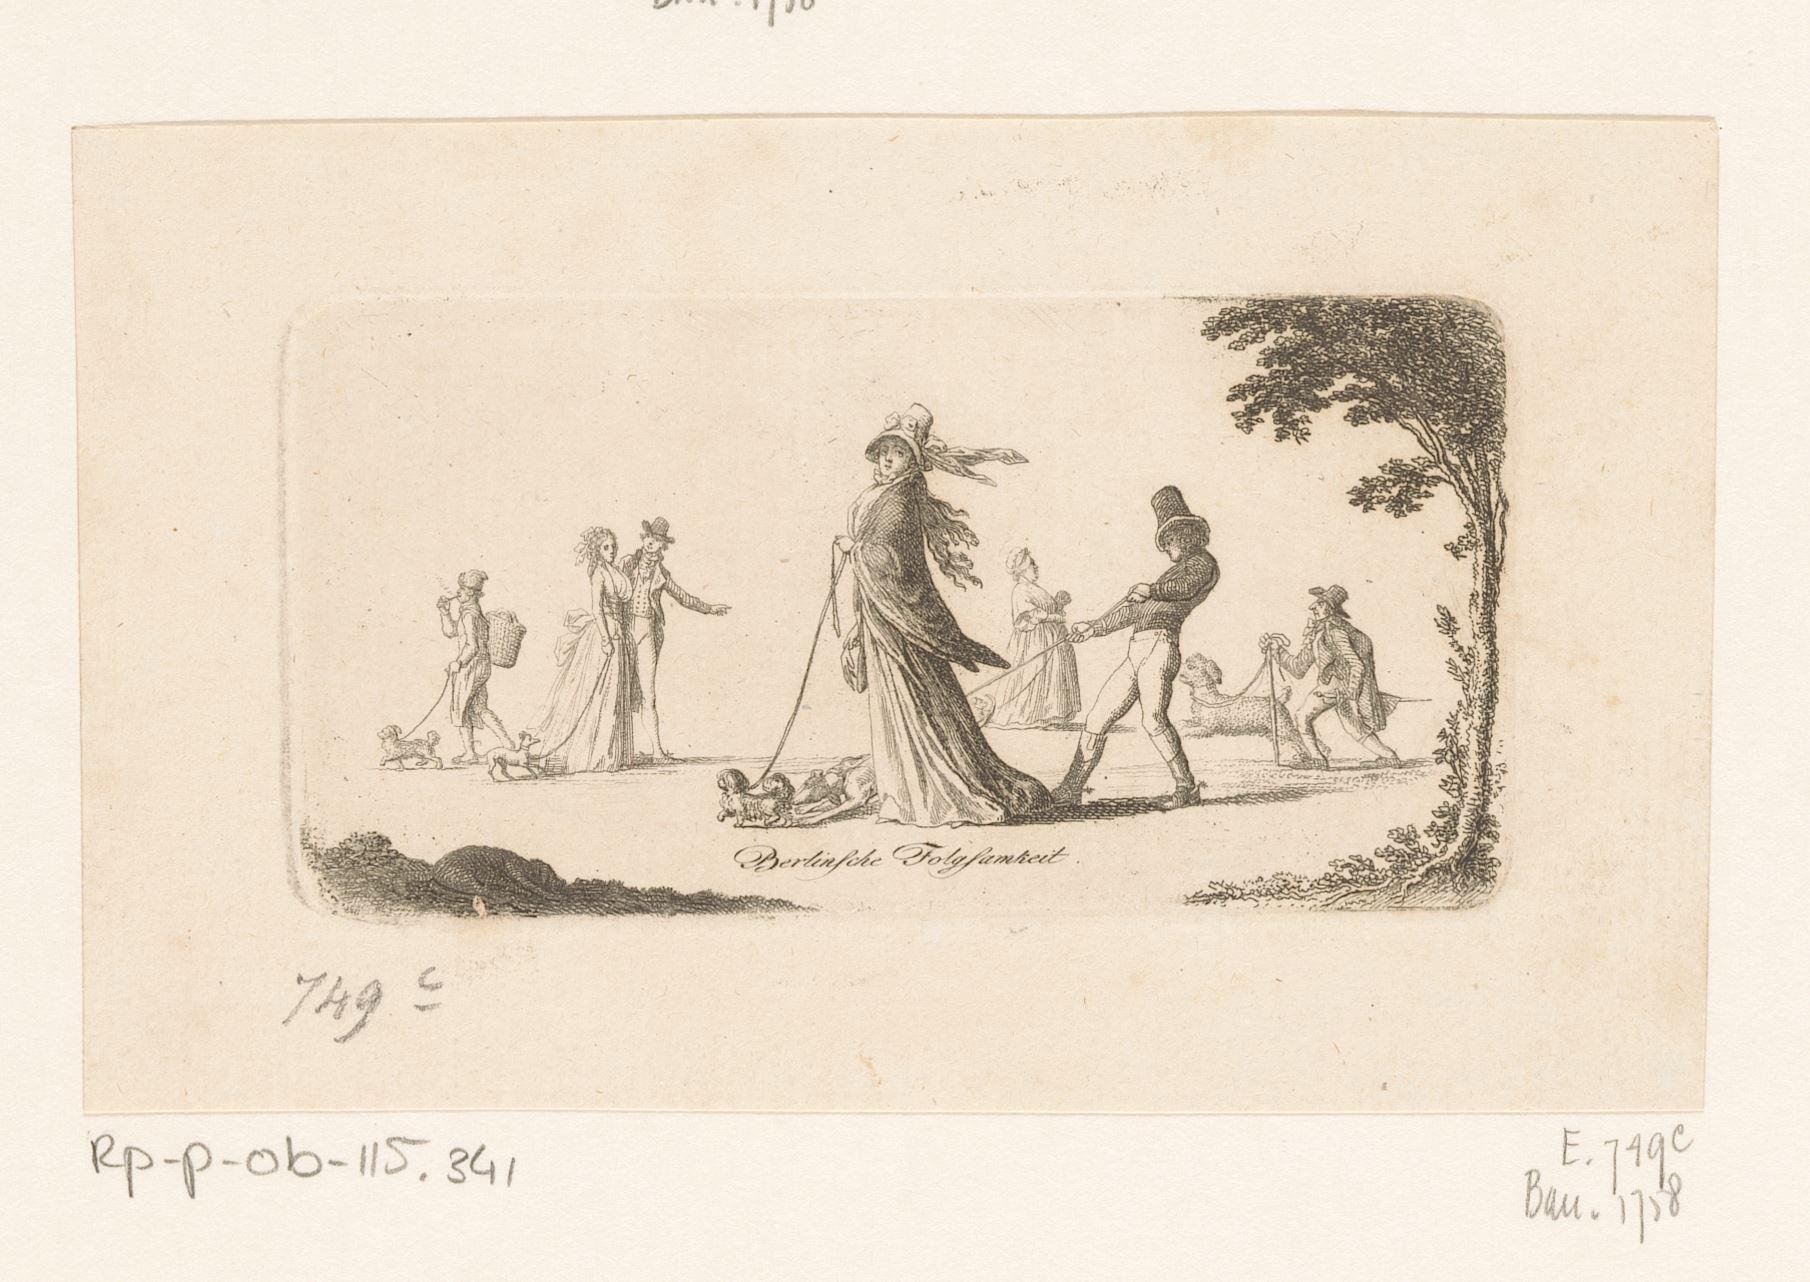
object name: print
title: Wandelaars met aangelijnde honden links van een boom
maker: daniel nikolaus chodowiecki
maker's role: draughtsman, print maker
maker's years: 1726-1801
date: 1794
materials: paper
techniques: etching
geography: berlin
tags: adult woman, adult man, walking the dog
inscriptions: collector's mark: Lugt 2228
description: Daniel Chodowiecki maakte deze prent naar aanleiding van de Berlijnse politieverordening dat honden aangelijnd moesten zijn bij het uitlaten.